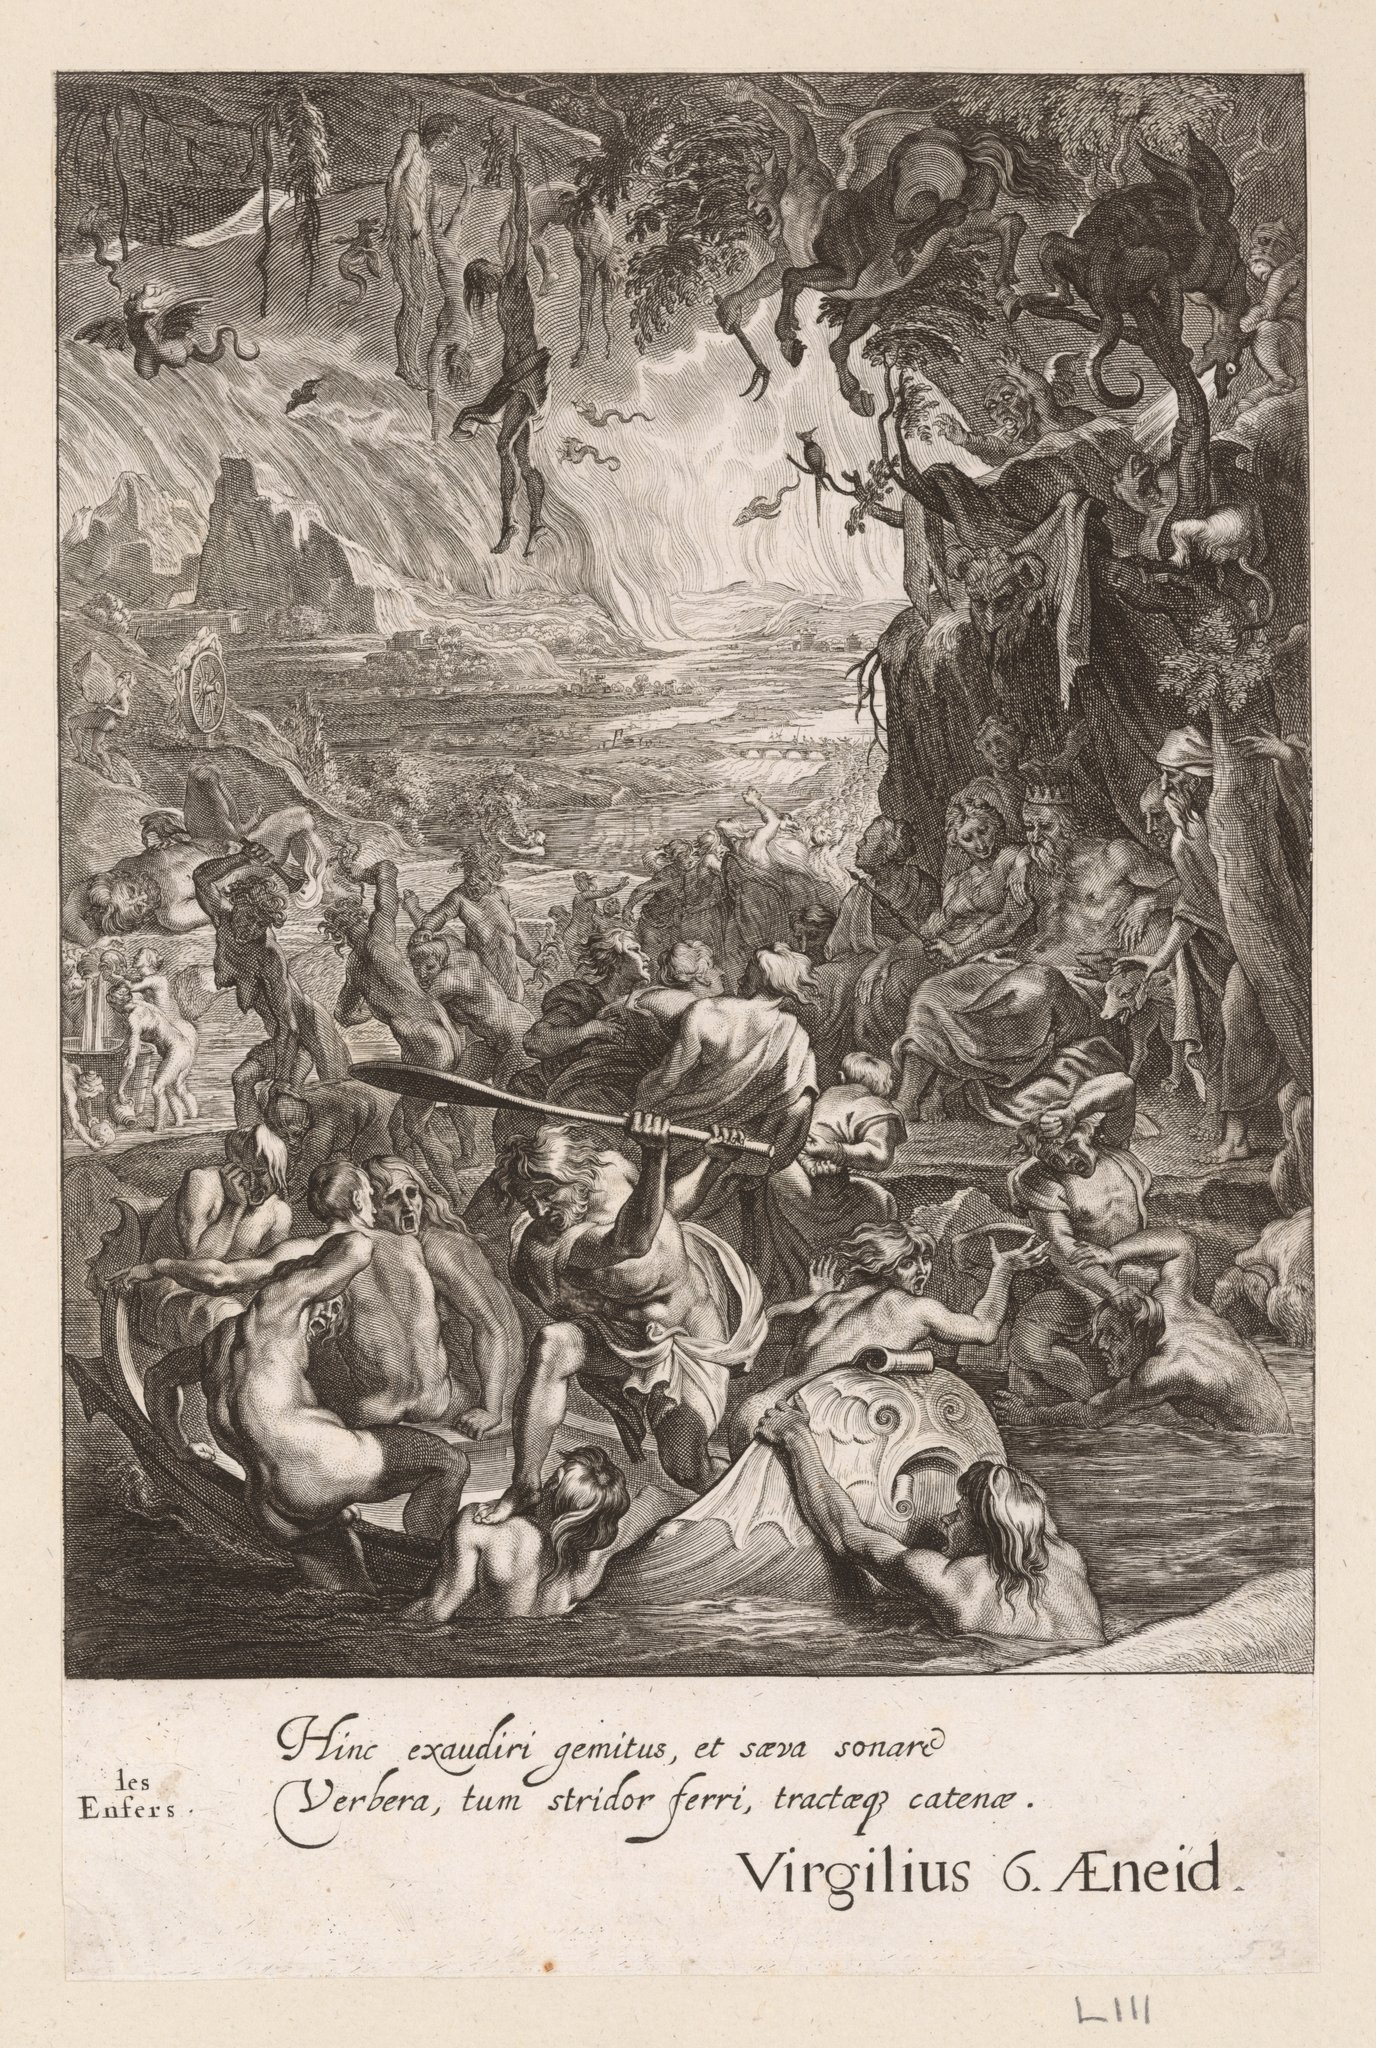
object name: print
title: Hell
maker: abraham van diepenbeeck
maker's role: artist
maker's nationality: flemish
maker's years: 1596-1675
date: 1655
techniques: engraving